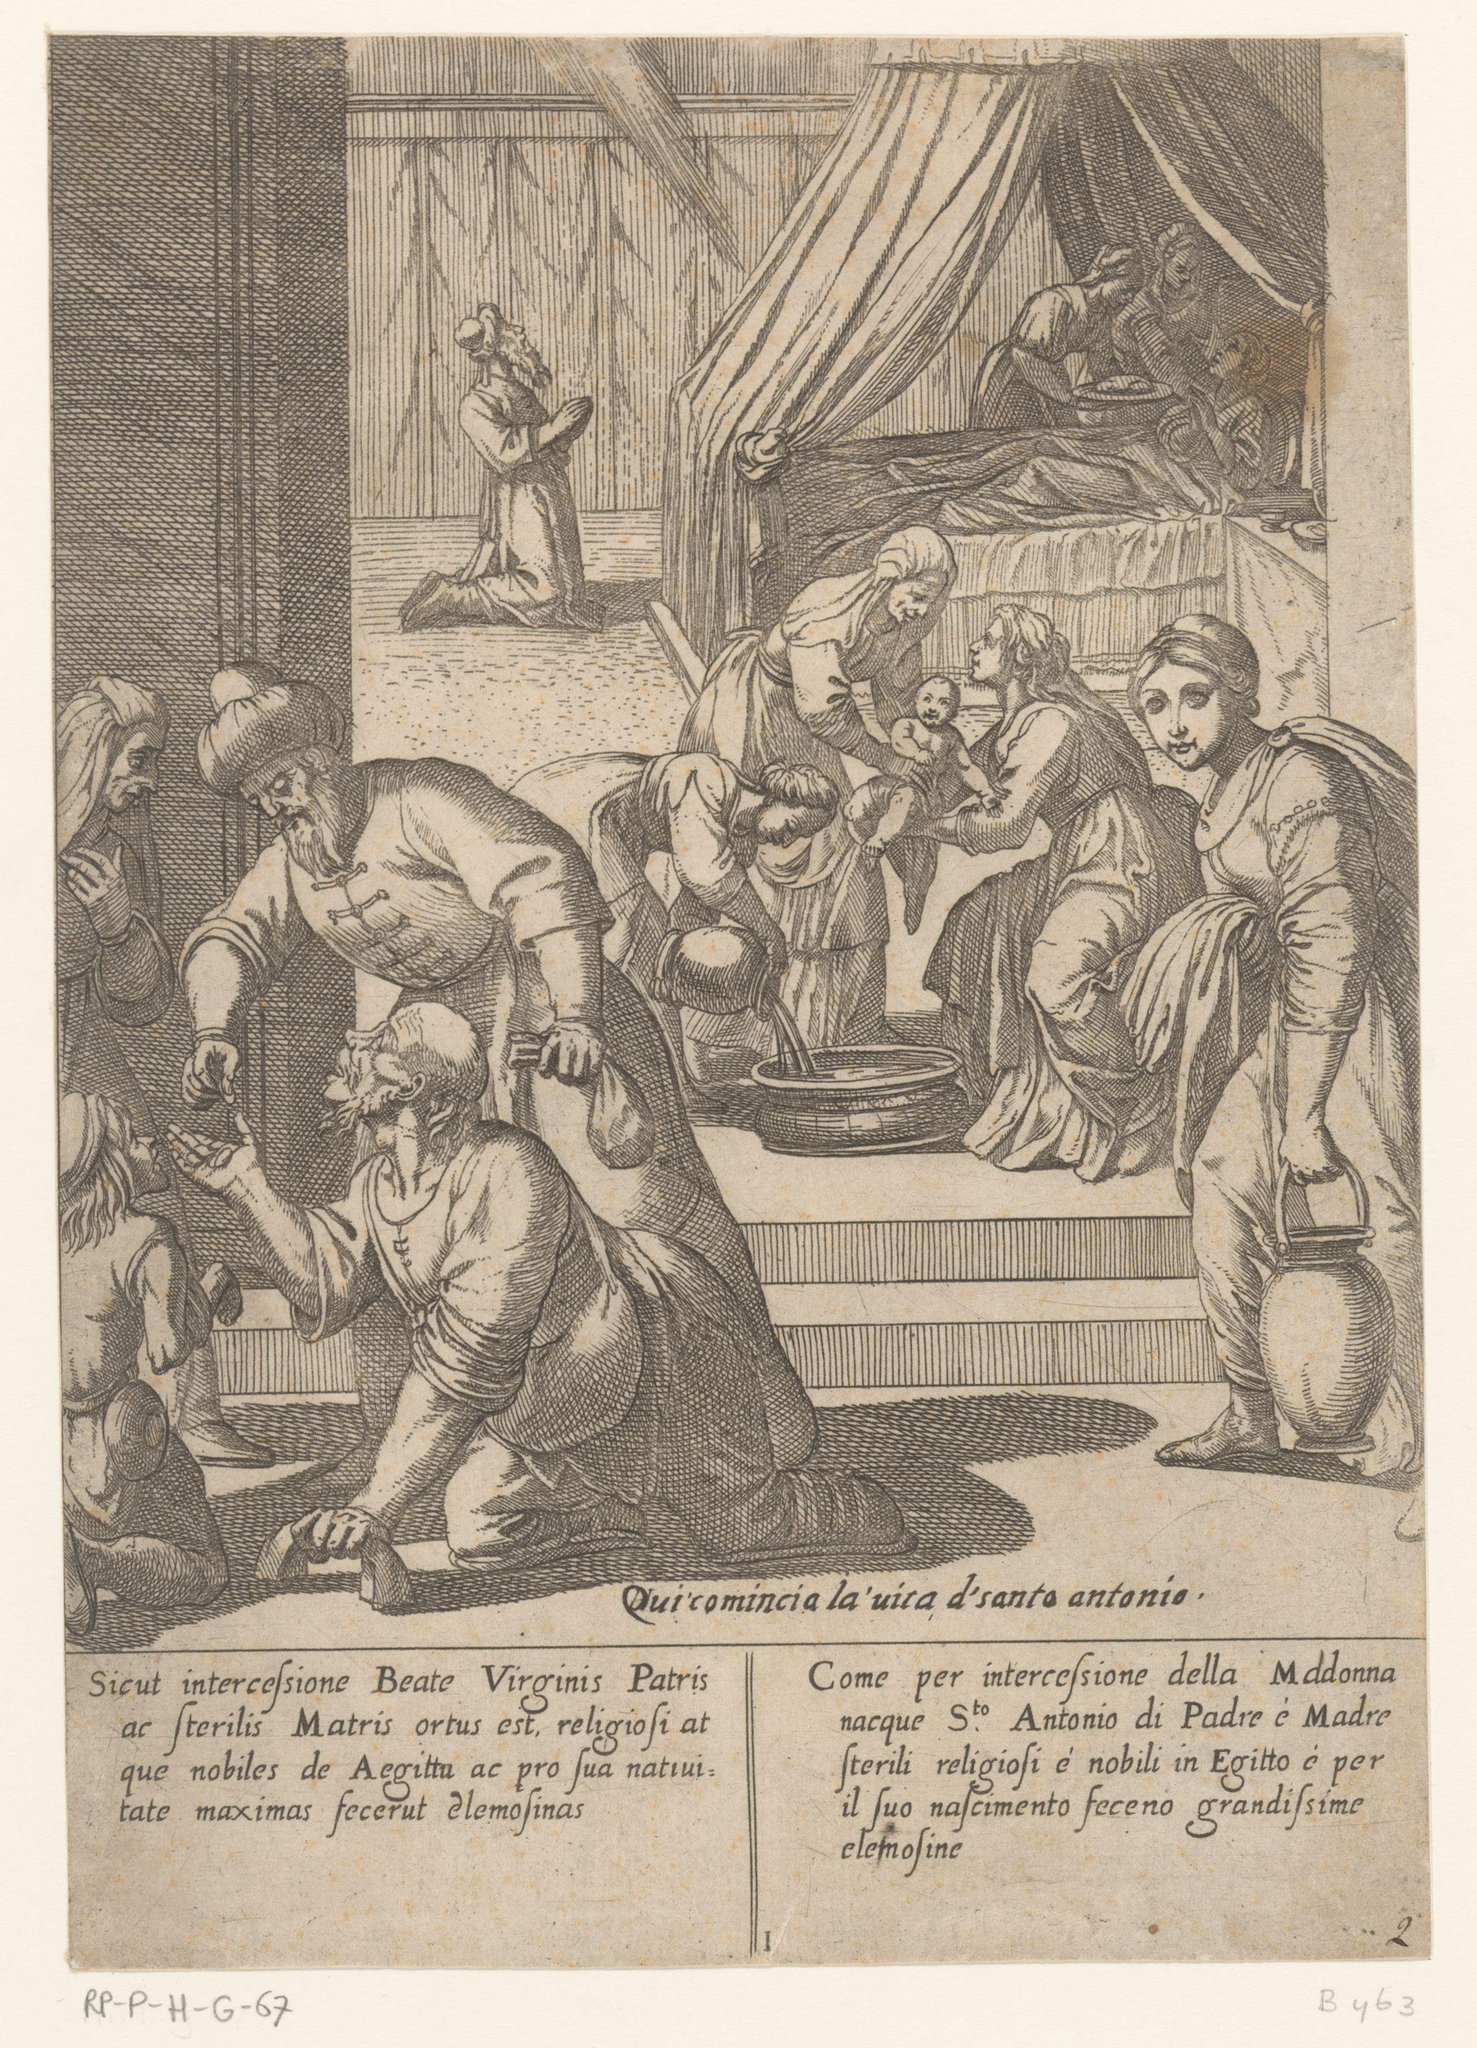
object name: print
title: Geboorte van de heilige Antonius de Grote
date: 1598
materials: paper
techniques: etching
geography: italy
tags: the hermit antony abbot (antonius abbas) of egypt, also called the great; possible attributes: bell, book, t-shaped staff, flames, pig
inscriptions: collector's mark: Lugt 11, number: ‘2’, collector's mark: ‘Hinloopen’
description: De zojuist geboren Antonius wordt gewassen door drie vroedvrouwen. Op de achtergrond ligt de moeder van Antonius in bed. Op de voorgrond geeft een man geld aan bedelaars. Italiaanse en Latijnse tekst in twee kolommen in de ondermarge.